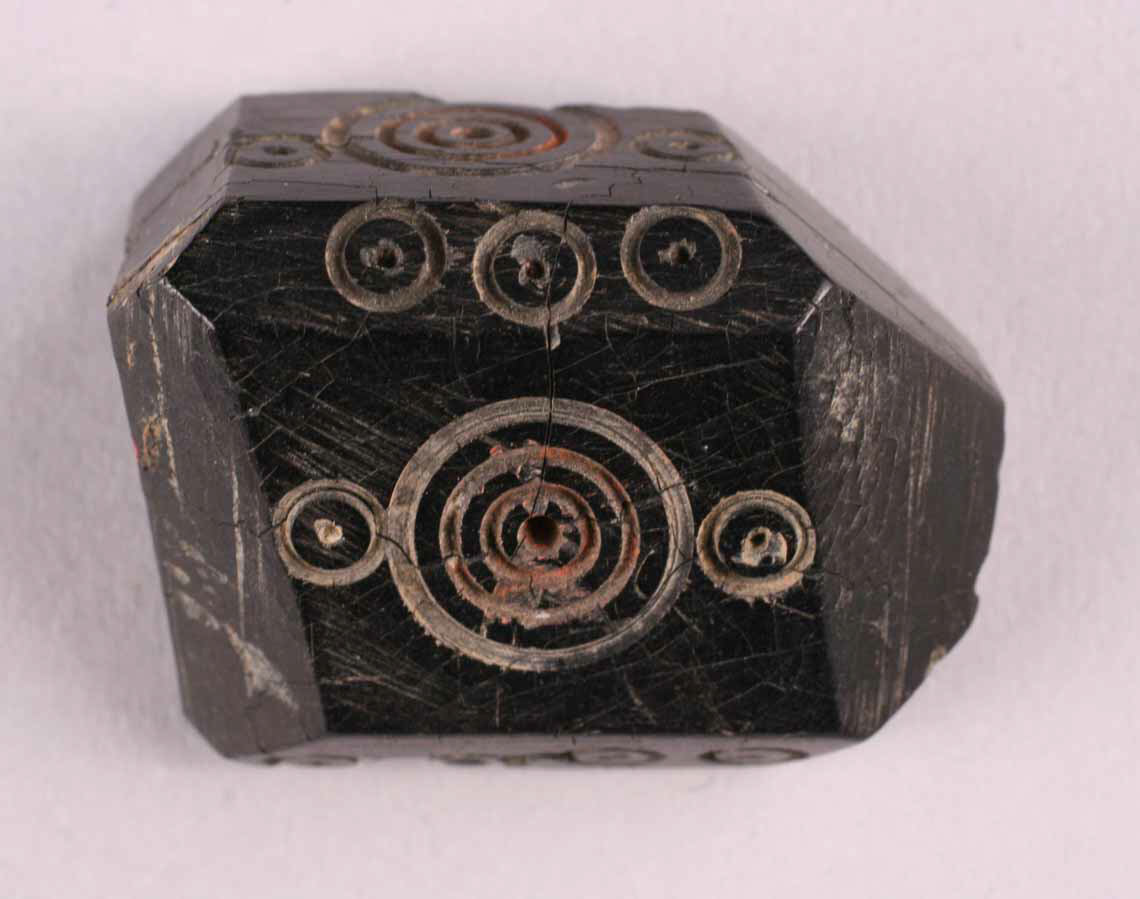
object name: bead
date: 701-1300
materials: stone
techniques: cutting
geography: iran